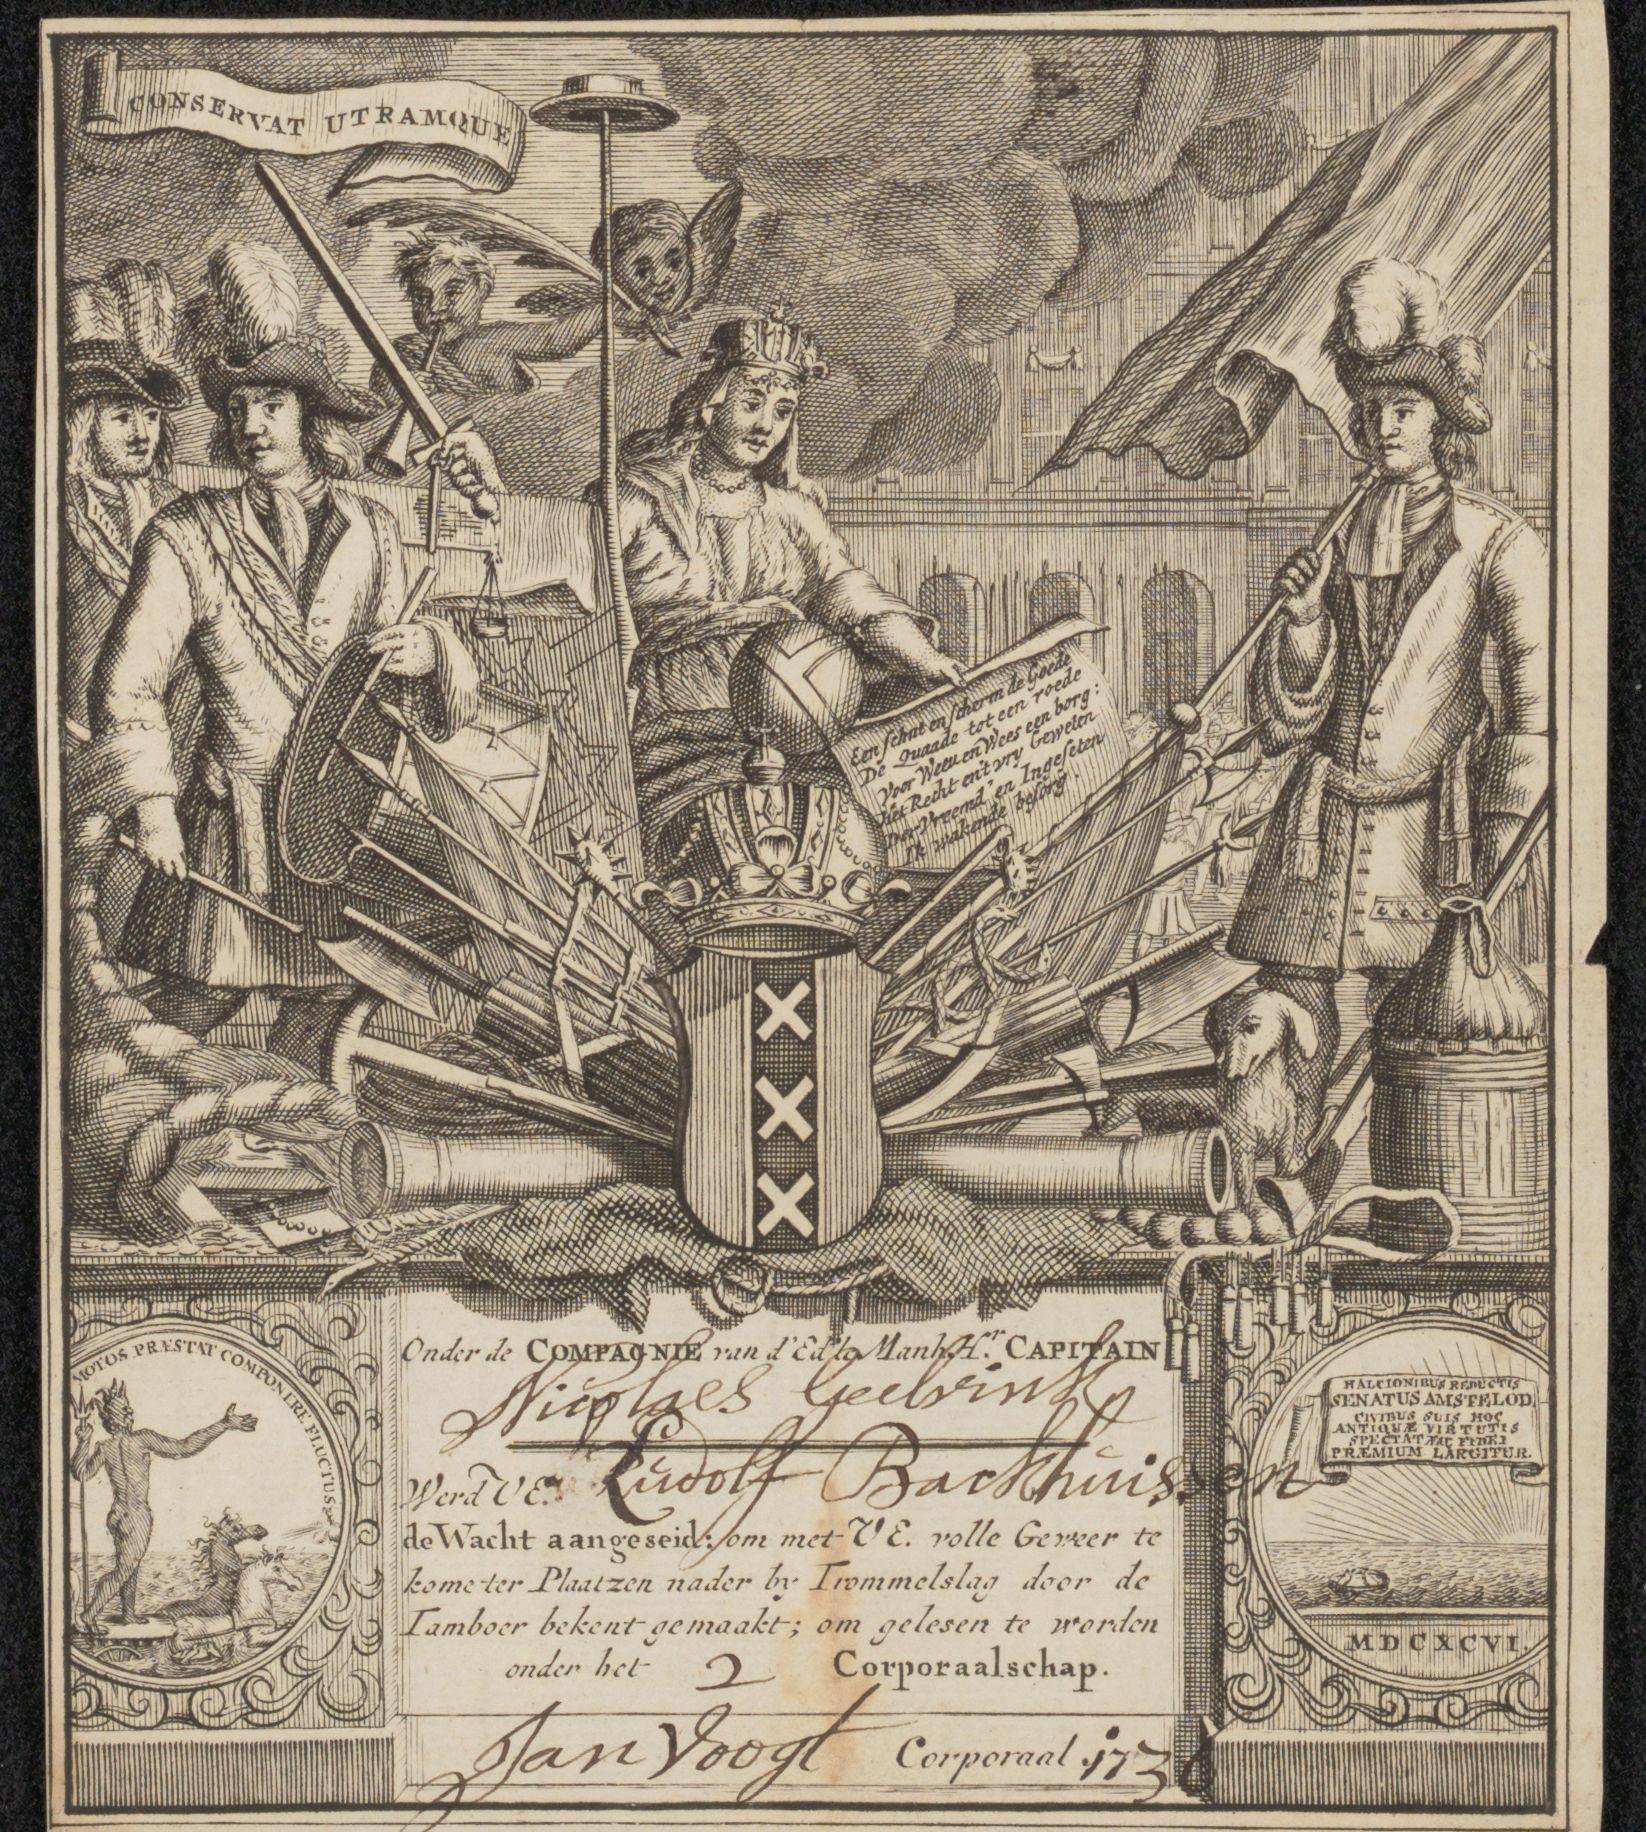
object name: schuttersbiljet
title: Schuttersbrief van Ludolf Backhuysen (II)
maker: Anonymous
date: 1736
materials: paper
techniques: printing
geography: amsterdam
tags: painter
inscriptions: collector's mark: Lugt 2233